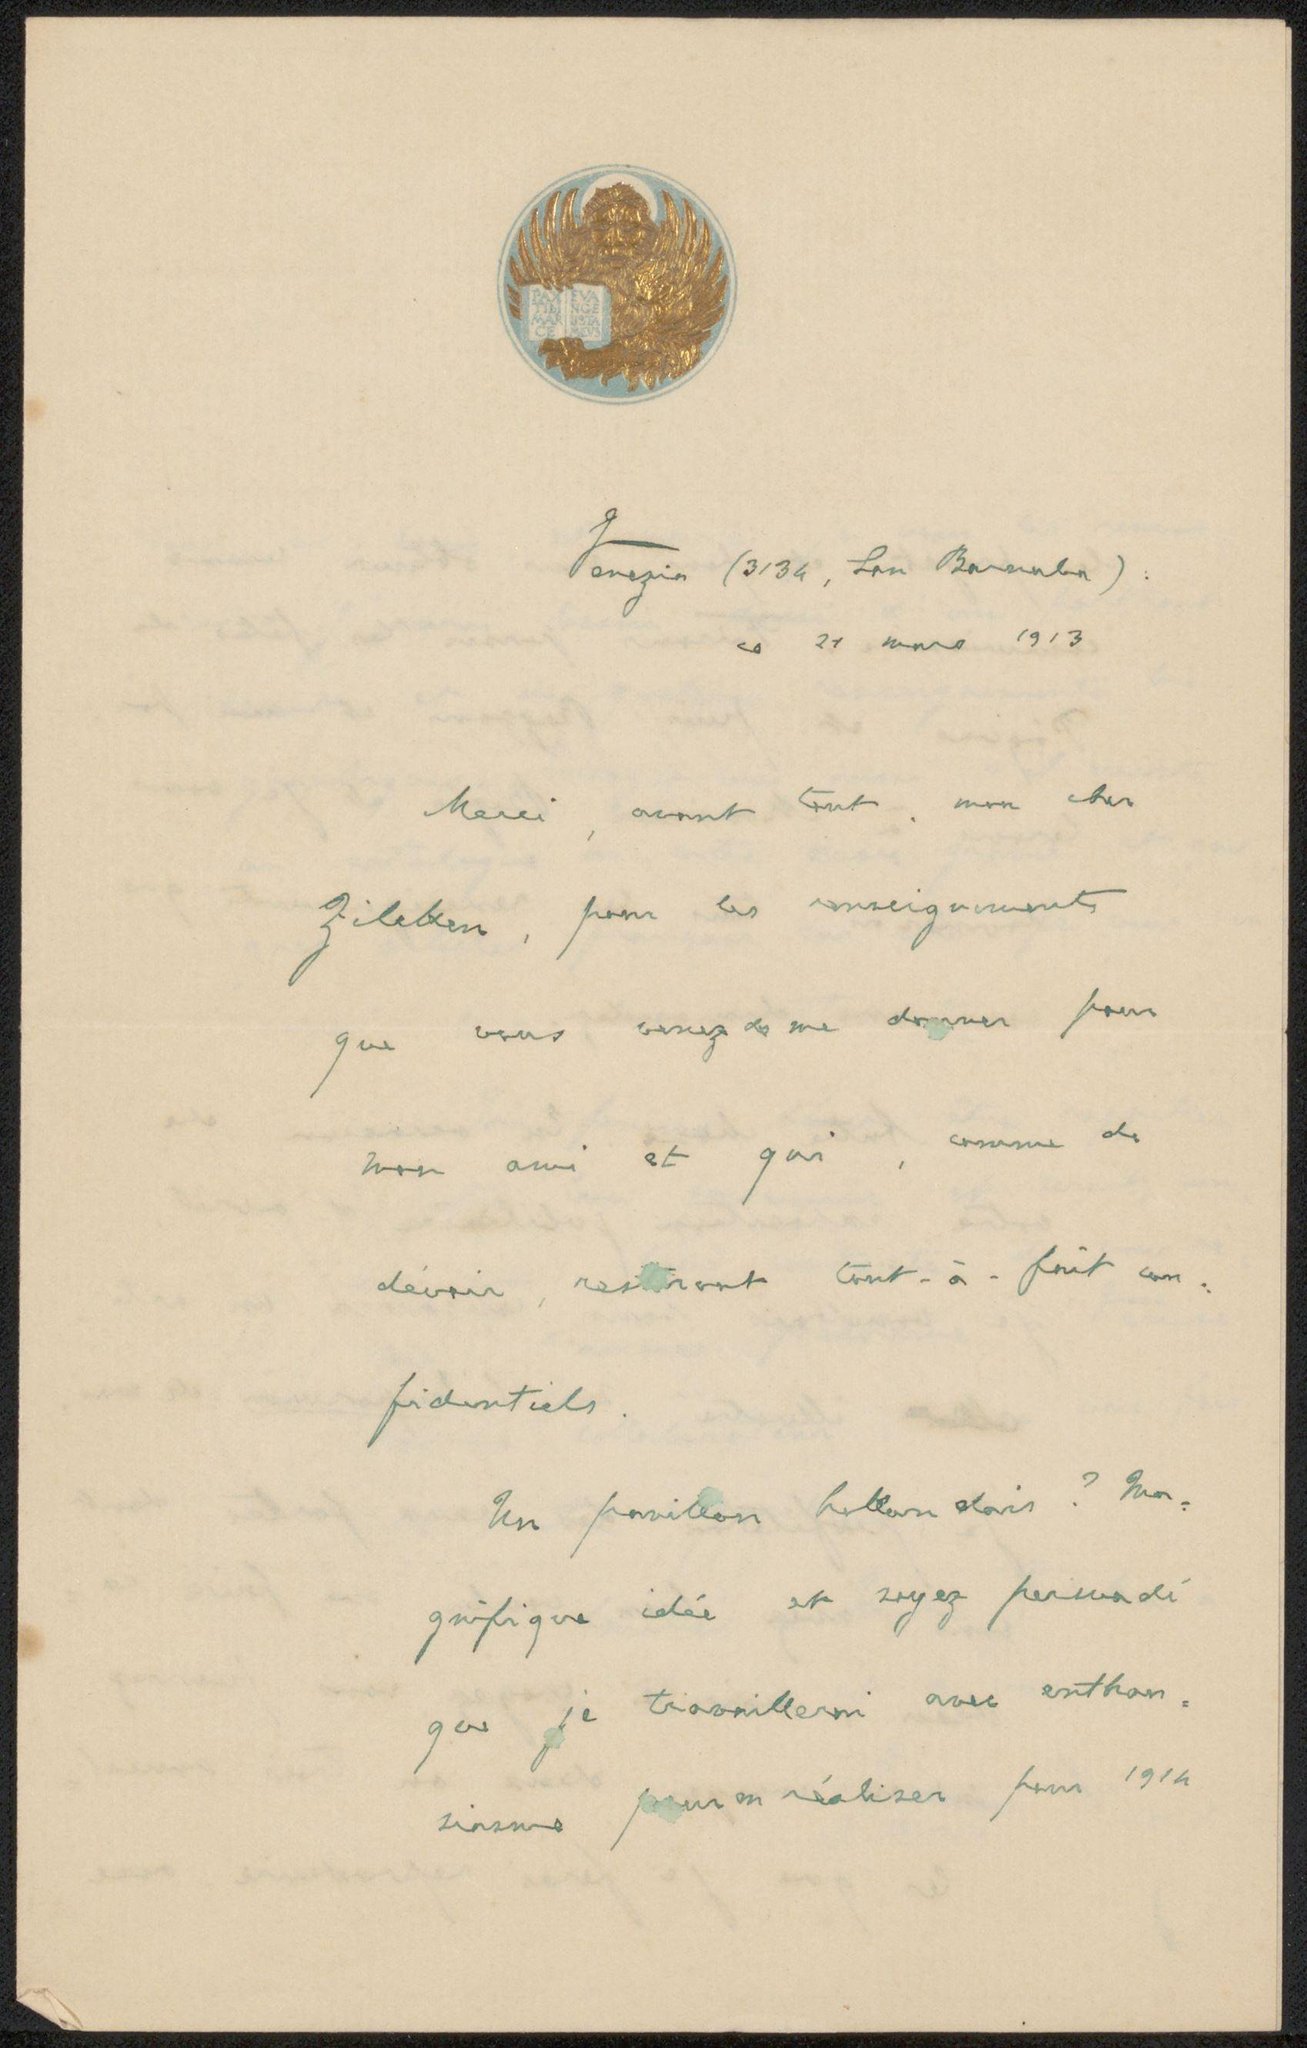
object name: letter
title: Brief aan Philip Zilcken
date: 1913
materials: ink, paper, pencil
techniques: pen, printing, writing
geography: venice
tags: leopoldo bizio gradenigo, the hague, painter, draughtsman, philip zilcken, the graphic arts, exhibition ~ art, printed matter, venice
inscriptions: collector's mark: ‘RPK’, watermark